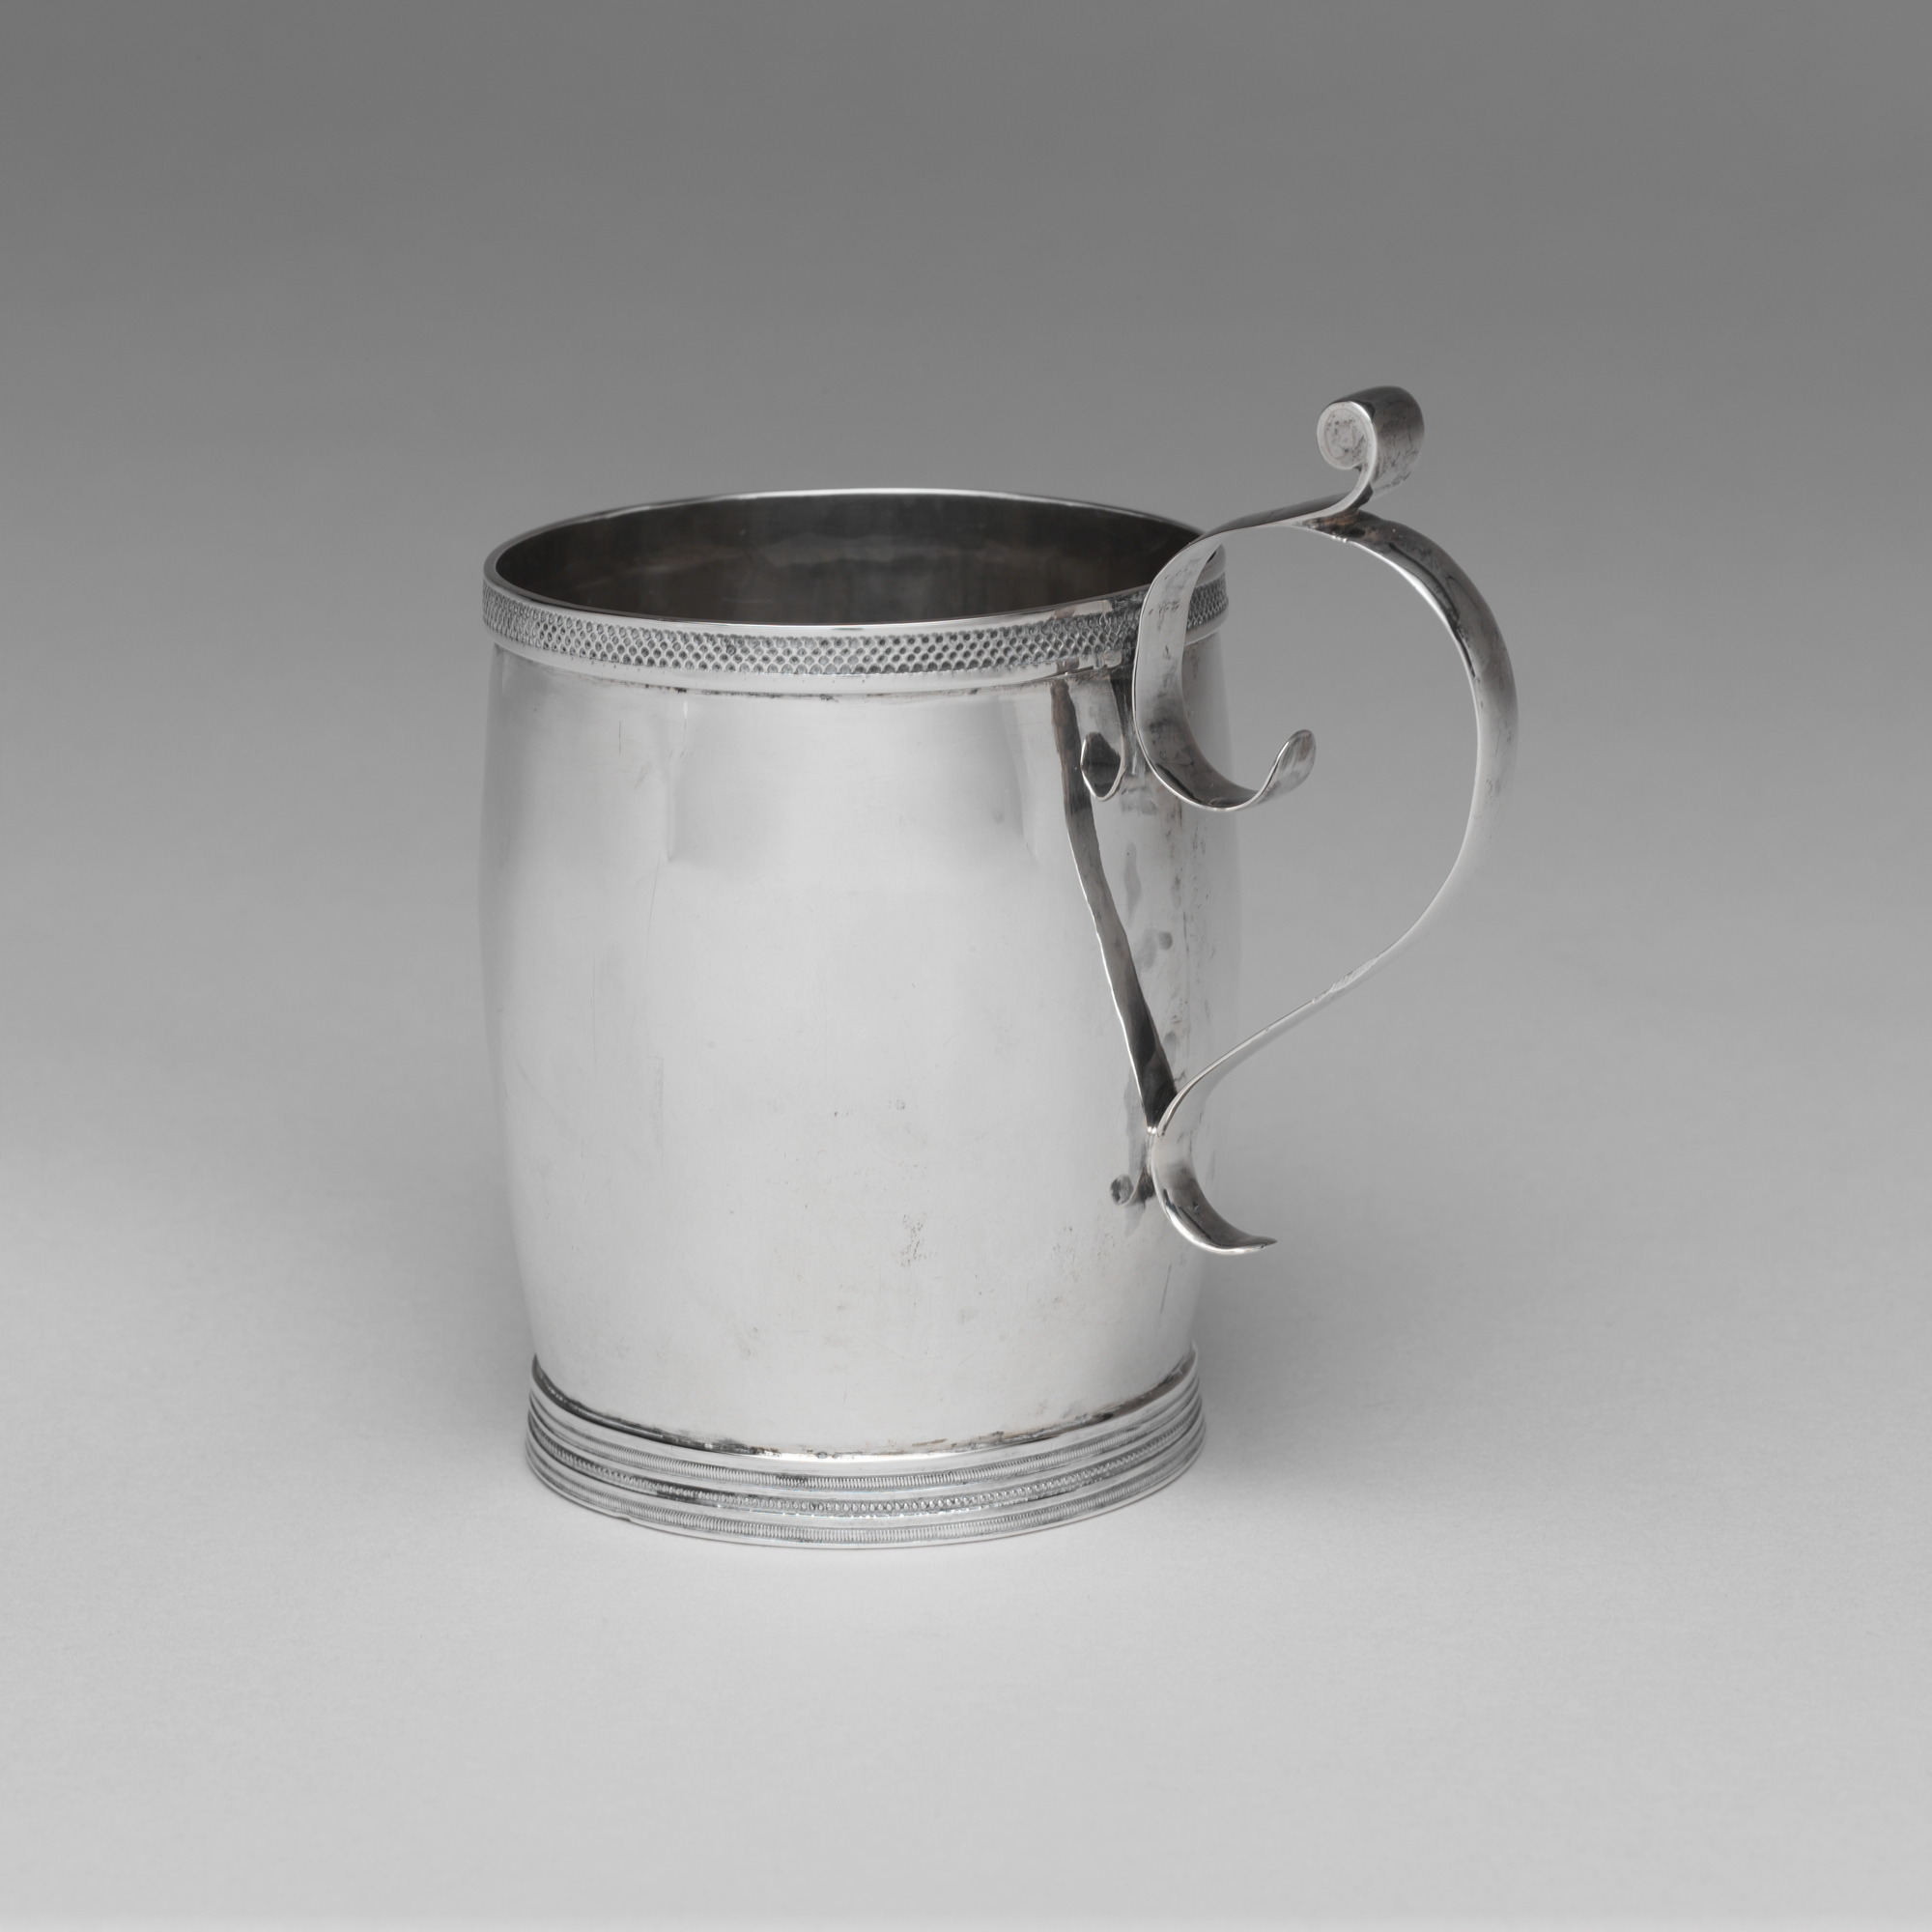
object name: mug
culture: american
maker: abraham fellows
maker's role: maker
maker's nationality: american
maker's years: 1786-1851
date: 1825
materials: silver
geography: united states